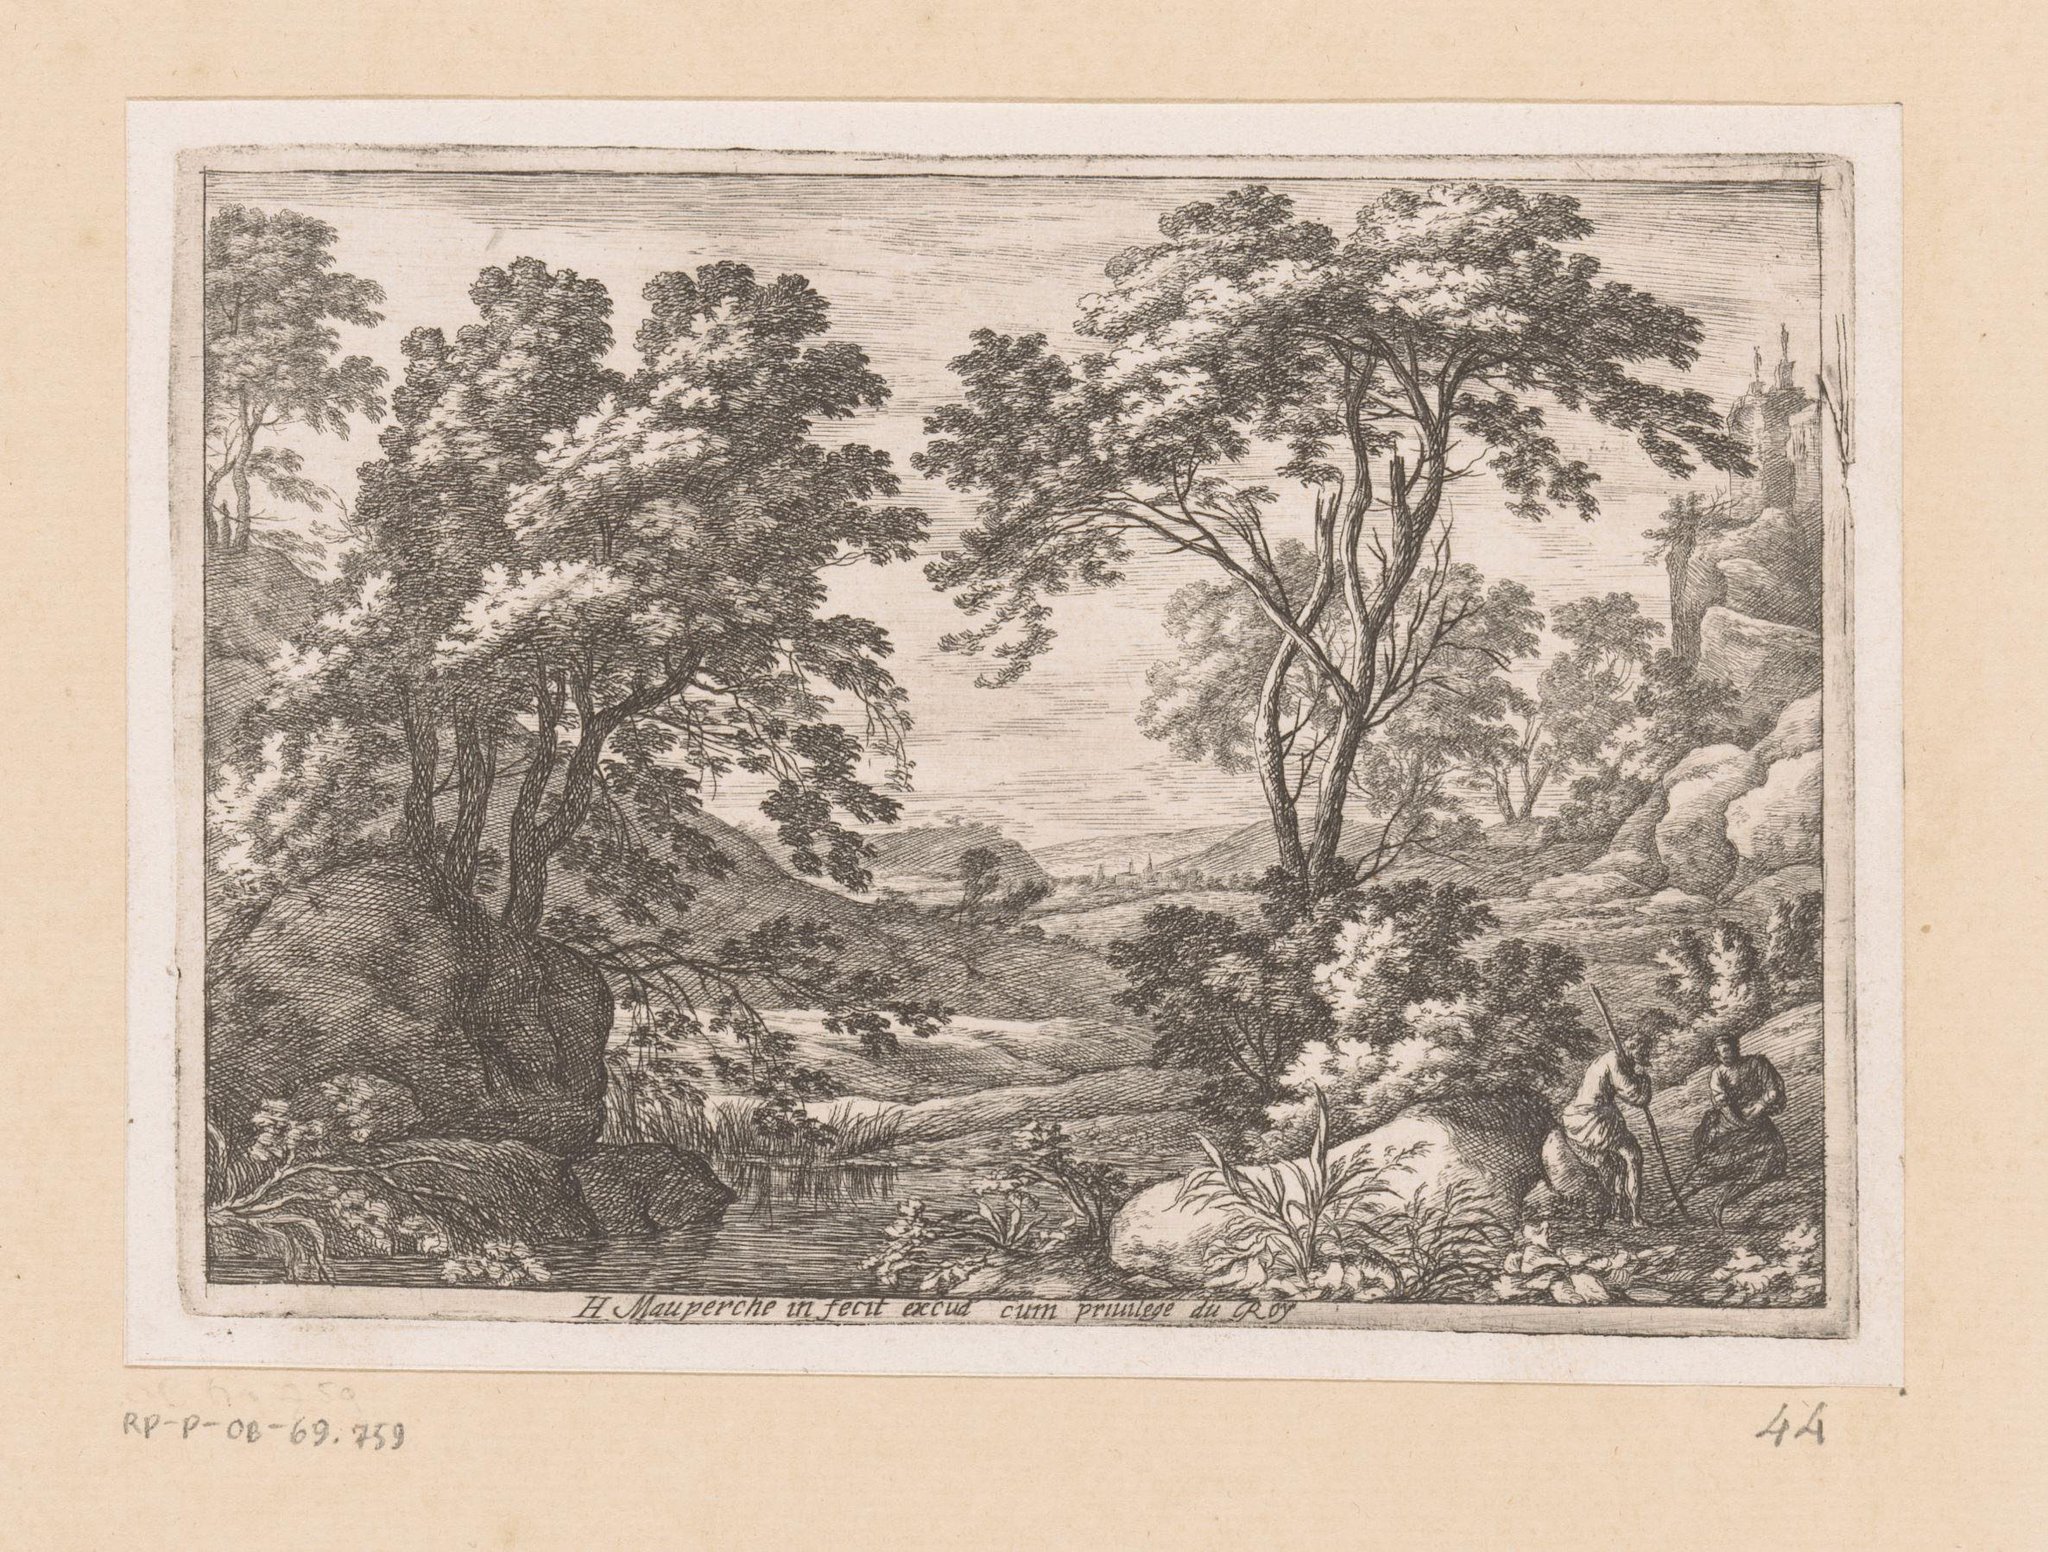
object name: print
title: Landschap met rustende man en vrouw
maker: henri mauperché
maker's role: painter, print maker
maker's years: 1602-1686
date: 1612-1686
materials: paper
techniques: engraving, etching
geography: paris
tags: landscapes (+ landscape with figures, staffage), resting - bb - out of doors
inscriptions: collector's mark: Lugt 240